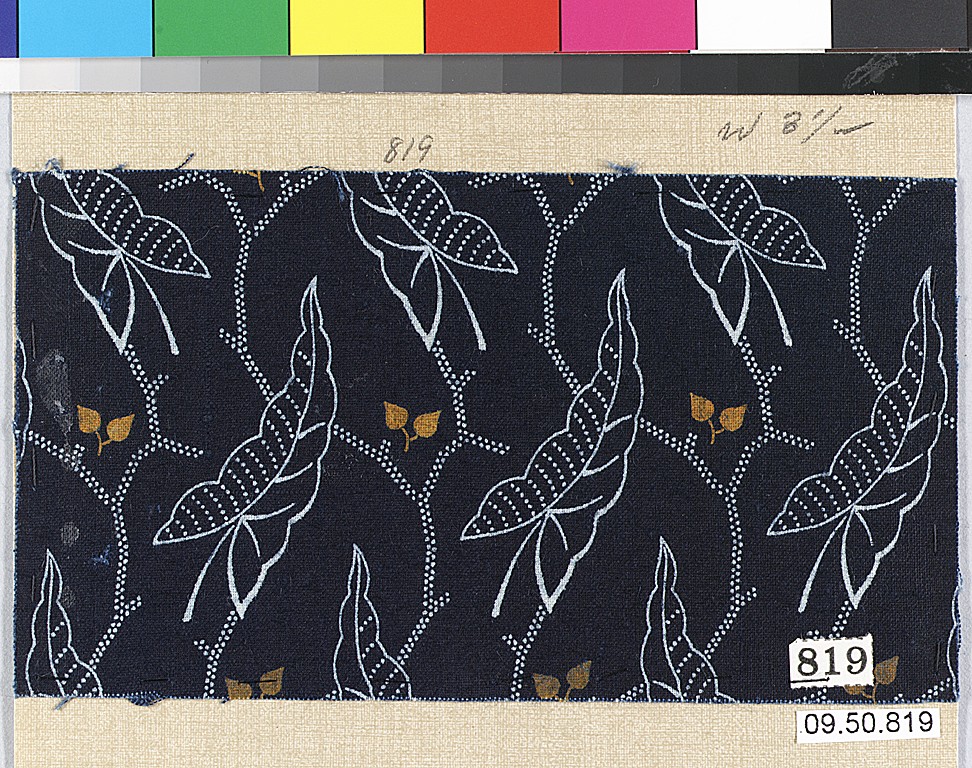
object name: piece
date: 1801-1900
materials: cotton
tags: leaves